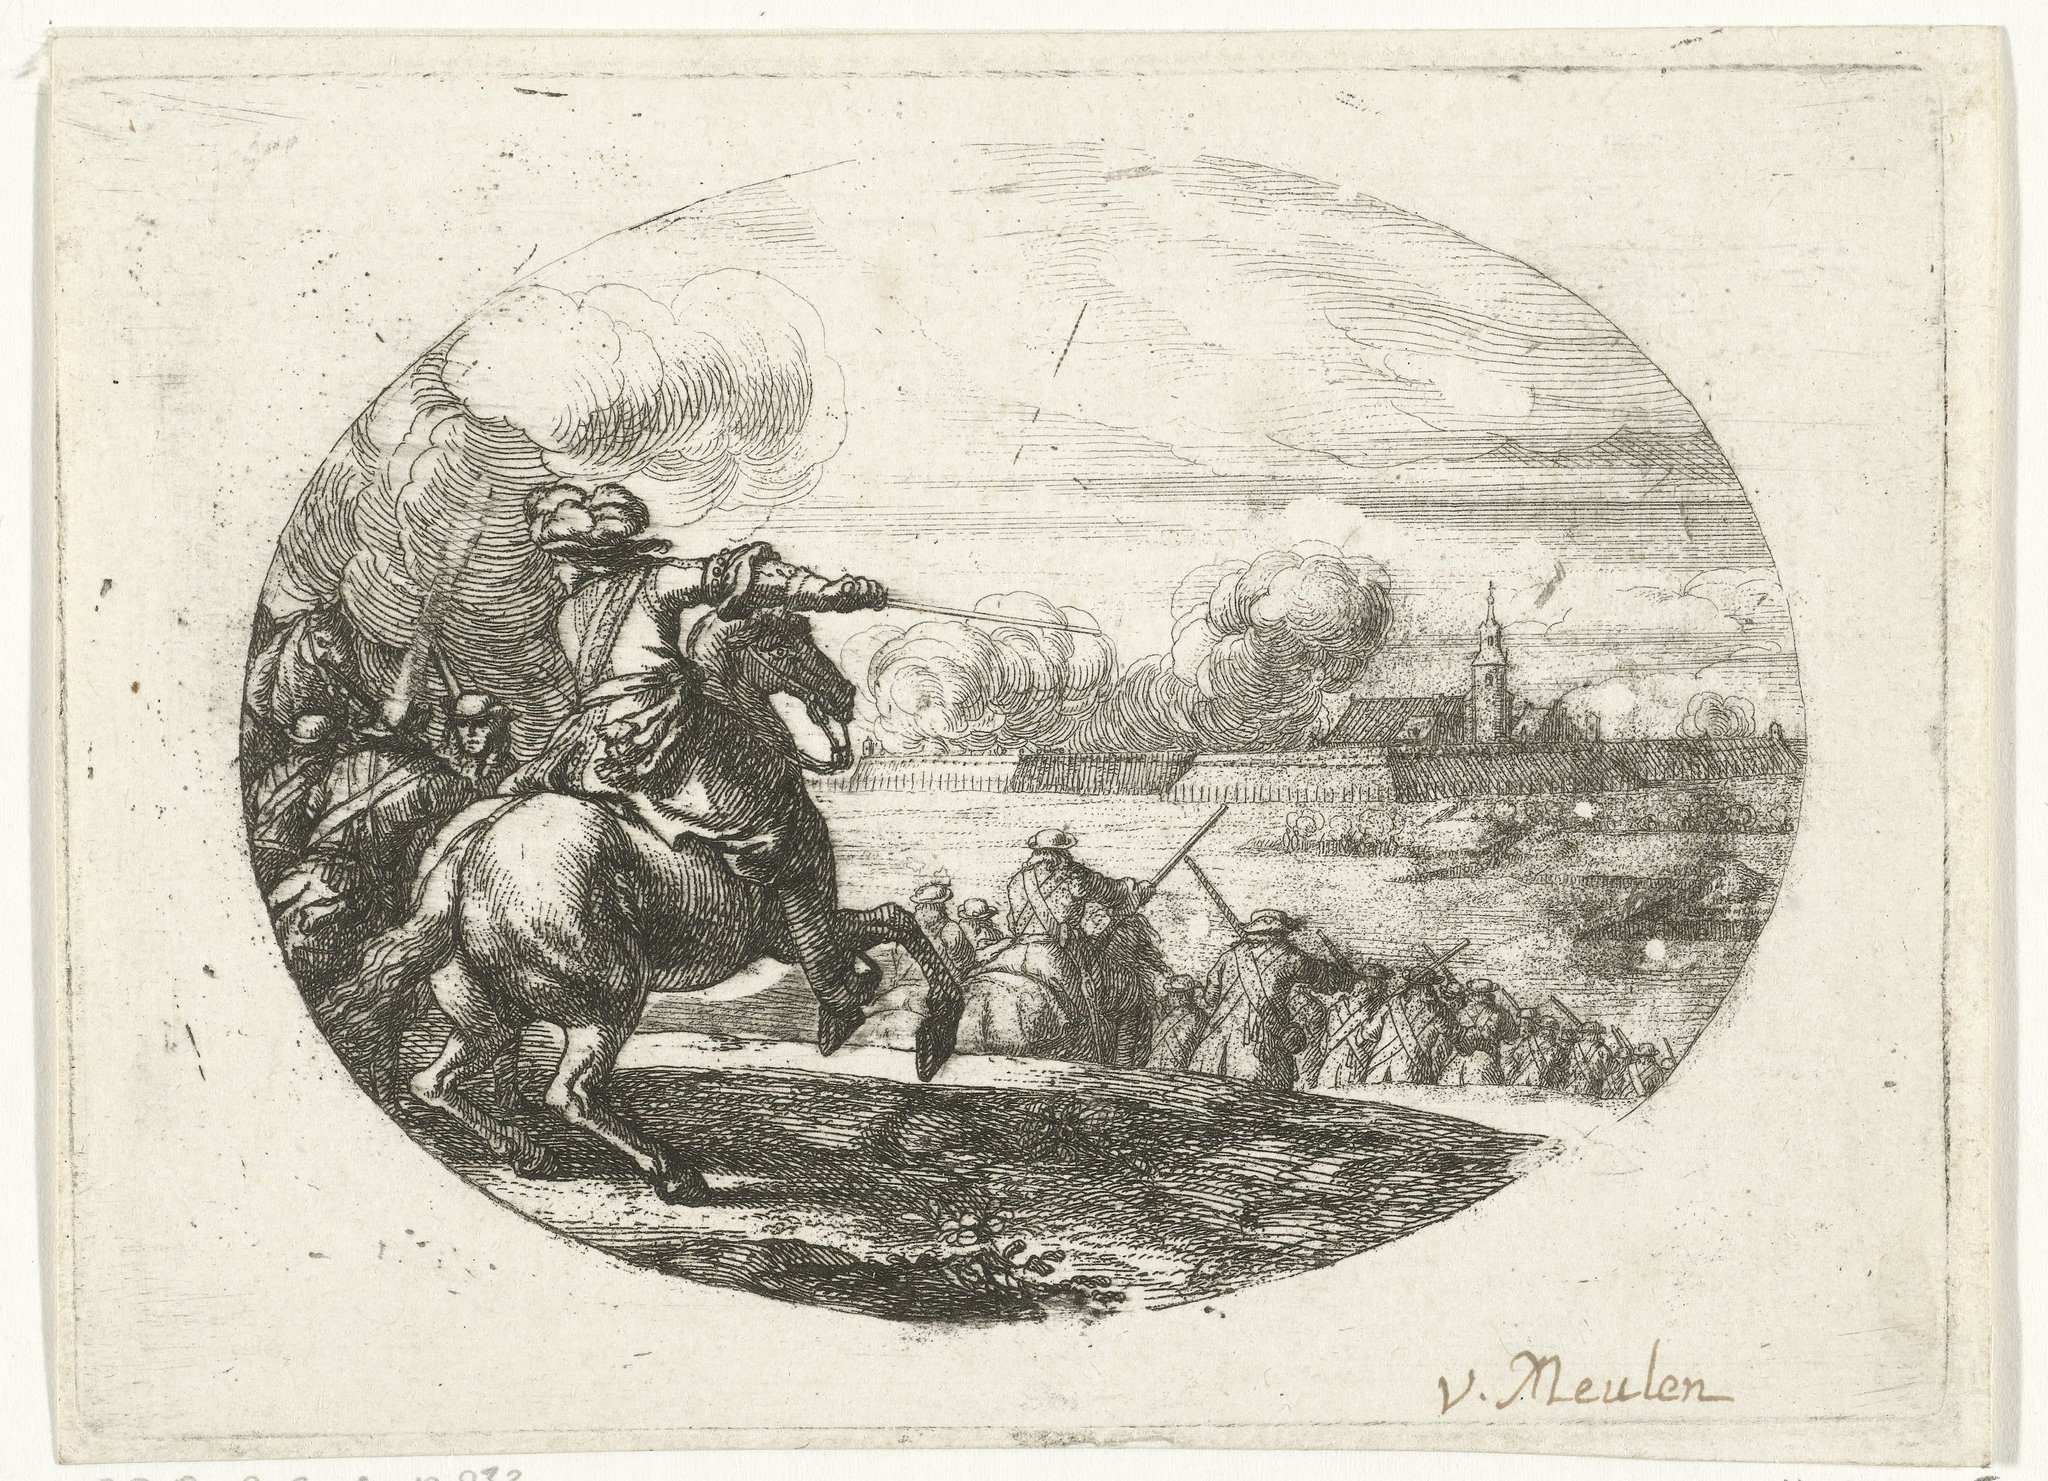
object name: print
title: Militaire voorstellingen uit het leven van Lodewijk XIV, koning van Frankrijk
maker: jan van huchtenburg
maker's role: draughtsman, painter, print maker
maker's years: 1647-1733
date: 1674-1733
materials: paper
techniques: etching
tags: lodewijk xiv (koning van frankrijk), historical persons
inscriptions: inscription: ‘V. Meulen’, collector's mark: Lugt 2228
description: Links ruiters en paarden, één ruiter wijst naar de stad aan de horizon. Rechts een stoet soldaten op de rug gezien.